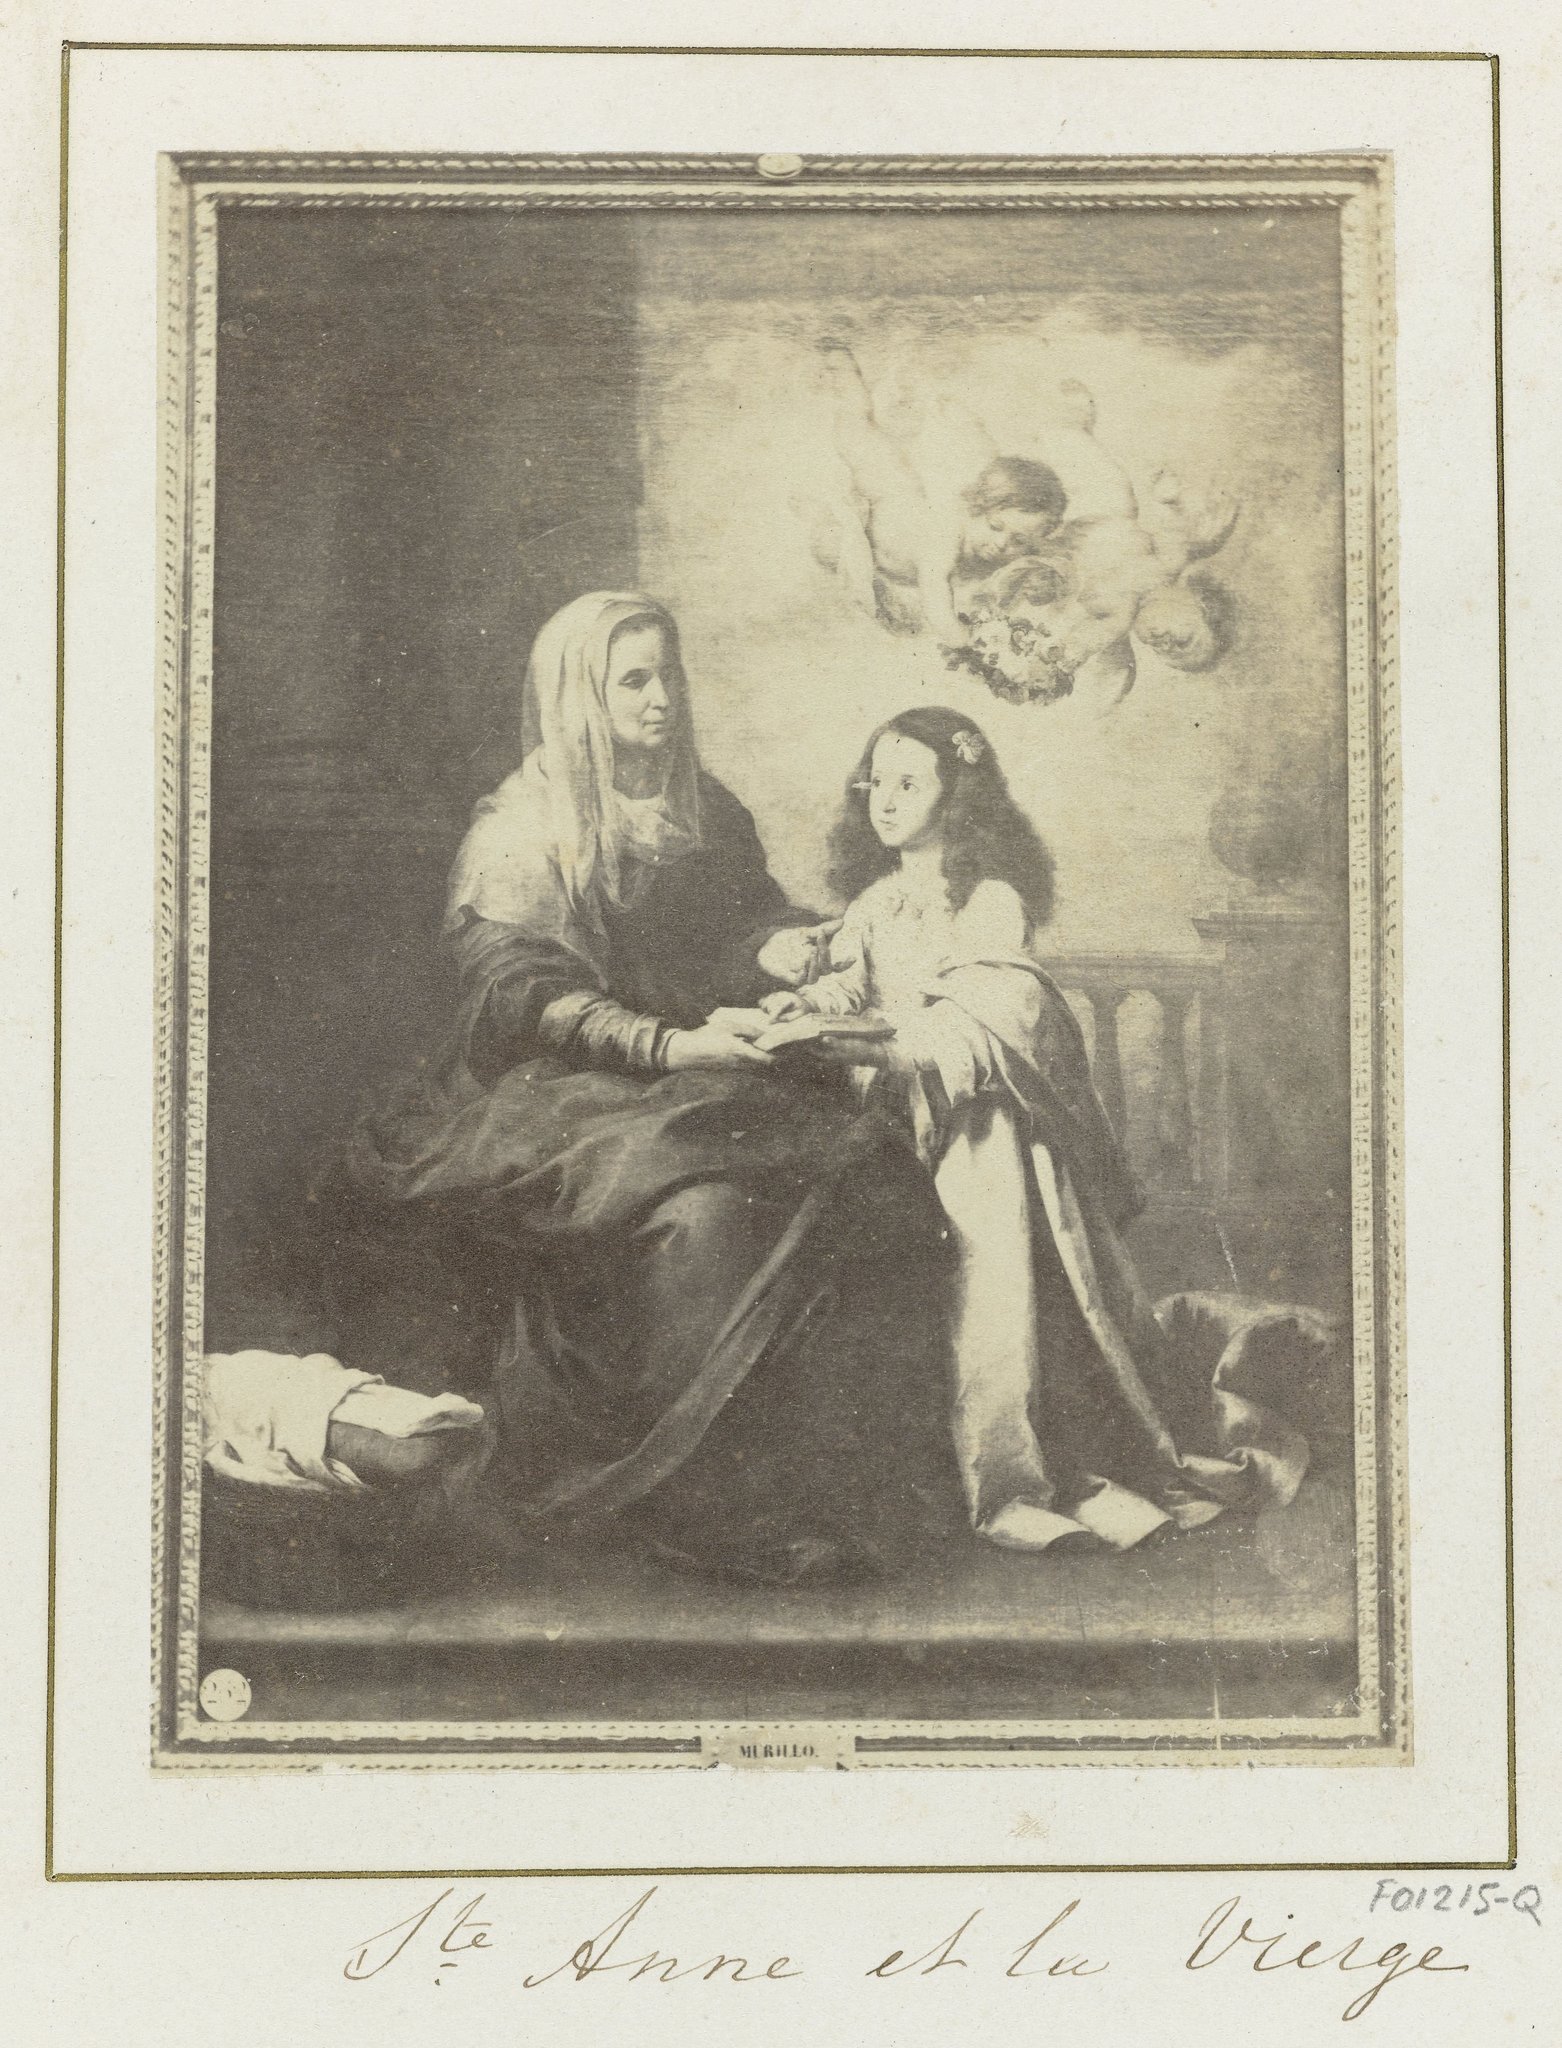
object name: photograph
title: Fotoreproductie van een schilderij door Bartolomé Esteban Murillo, voorstellend Anna en haar dochter Maria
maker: Anonymous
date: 1860-1875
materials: photographic support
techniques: albumen print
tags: anna teaching mary to read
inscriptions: inscription: ‘[...]’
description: Onderdeel van Reisalbum met opnames van kunstwerken, personen en bezienswaardigheden in Spanje.